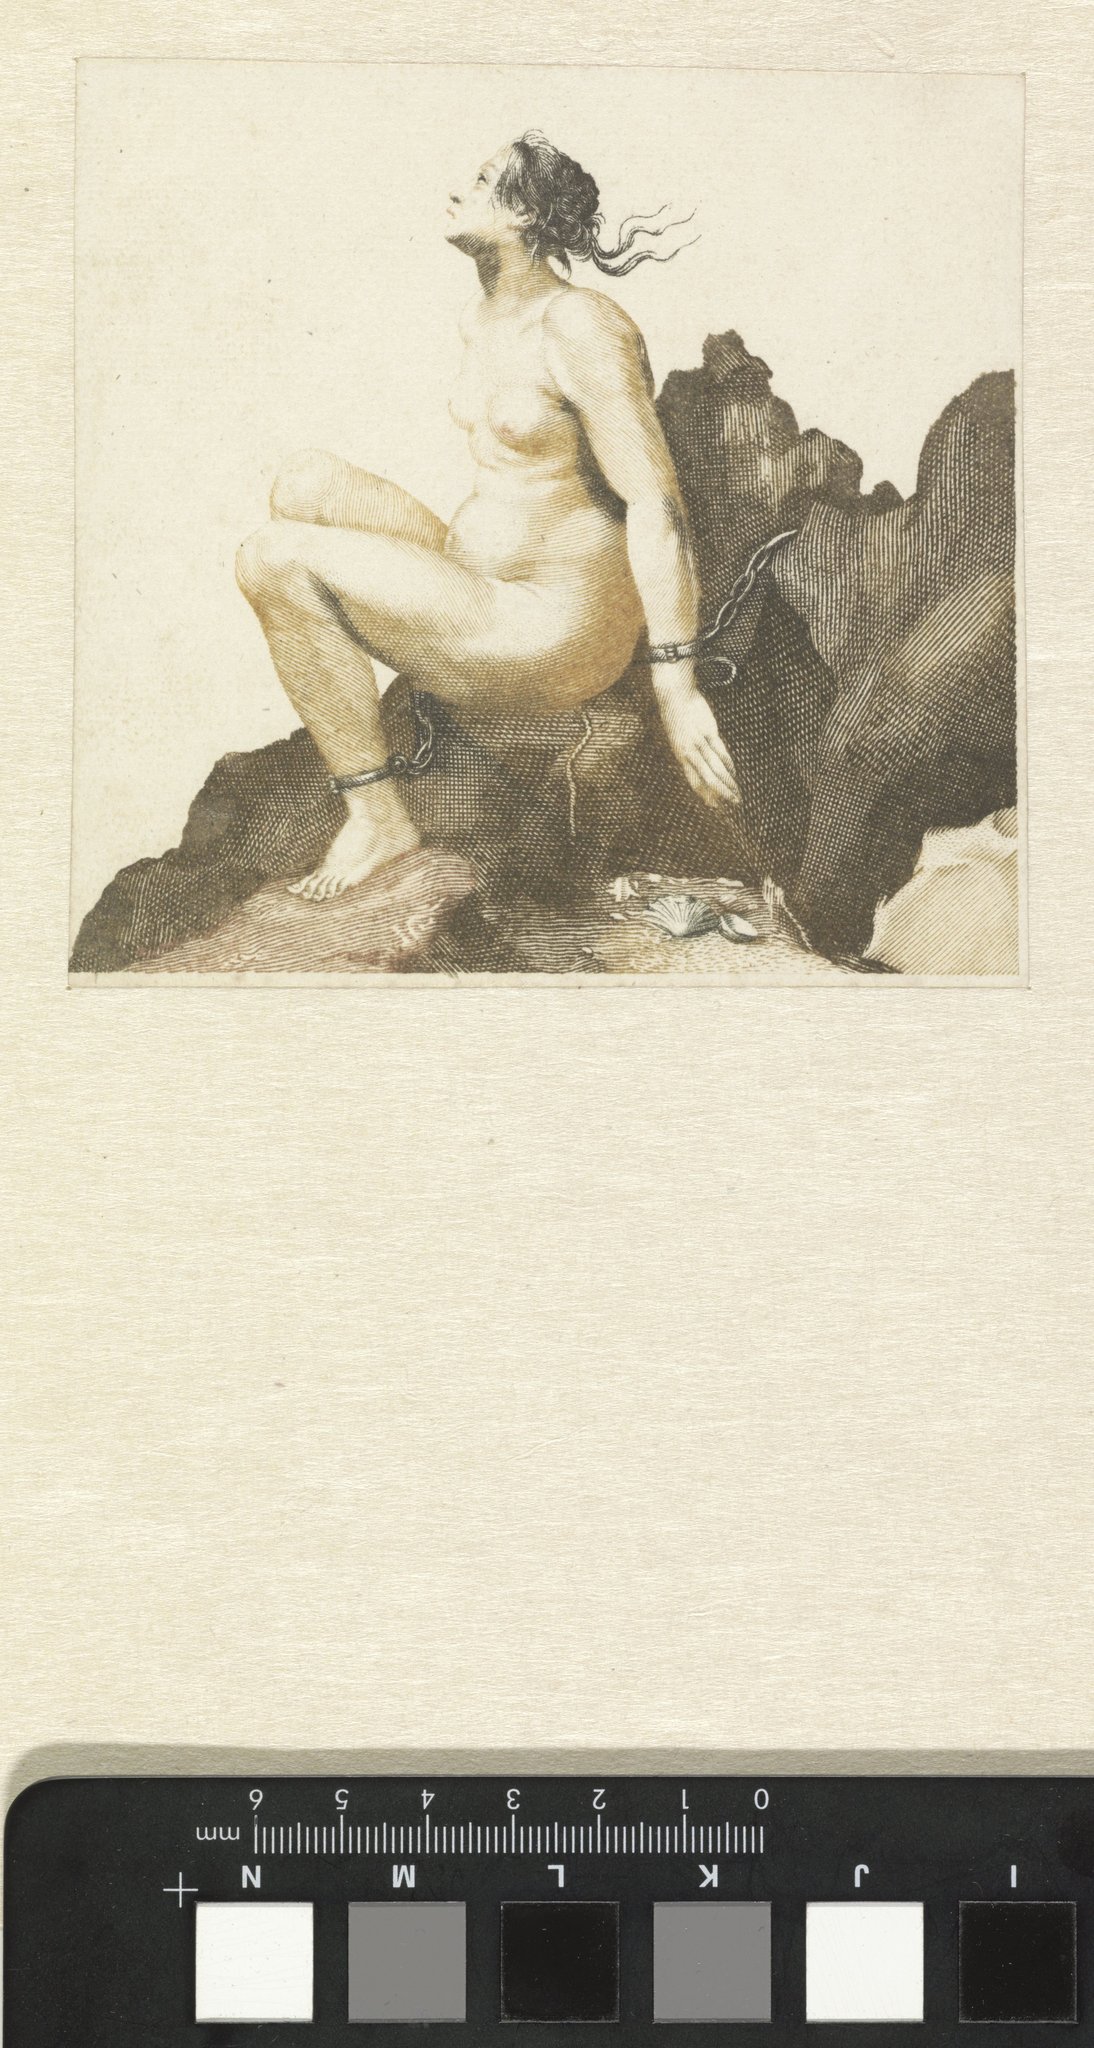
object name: print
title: Andromeda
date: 1688-1698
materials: paper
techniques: printing, engraving, lithography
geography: netherlands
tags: andromeda chained to the rock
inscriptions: collector's mark: Lugt 2228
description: Andromeda geketend aan de rots, naast haar enkele schelpen.